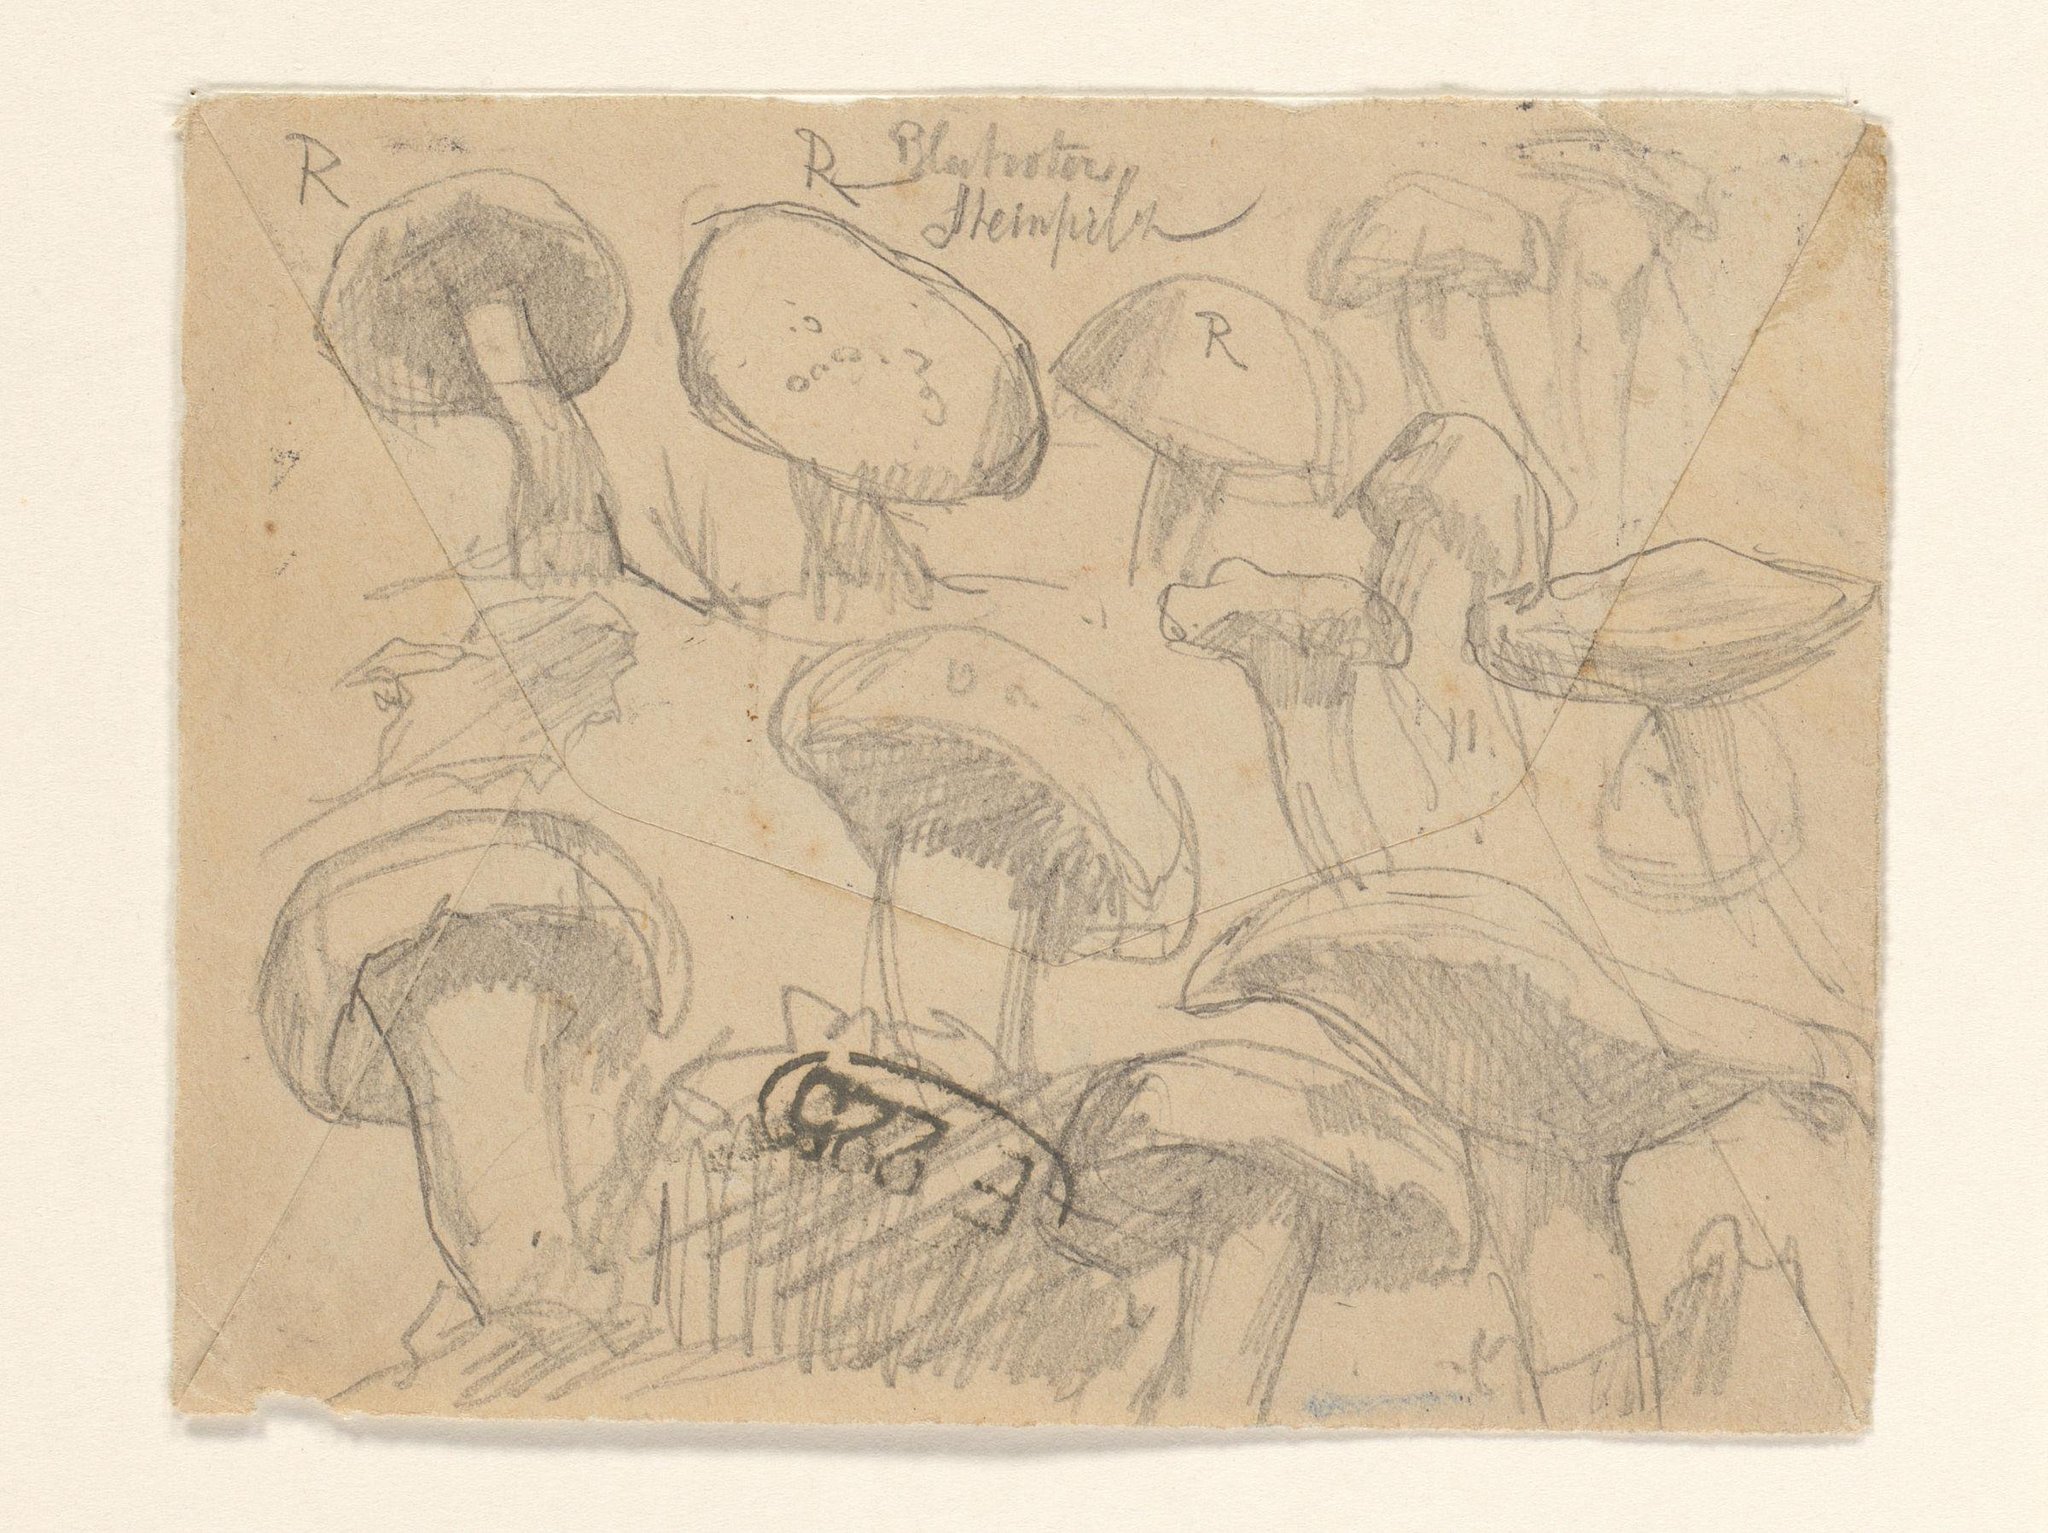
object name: drawing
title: Schetsblad met diverse paddenstoelen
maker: august allebé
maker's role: draughtsman, print maker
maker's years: 1838-1927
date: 1848-1927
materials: paper, pencil